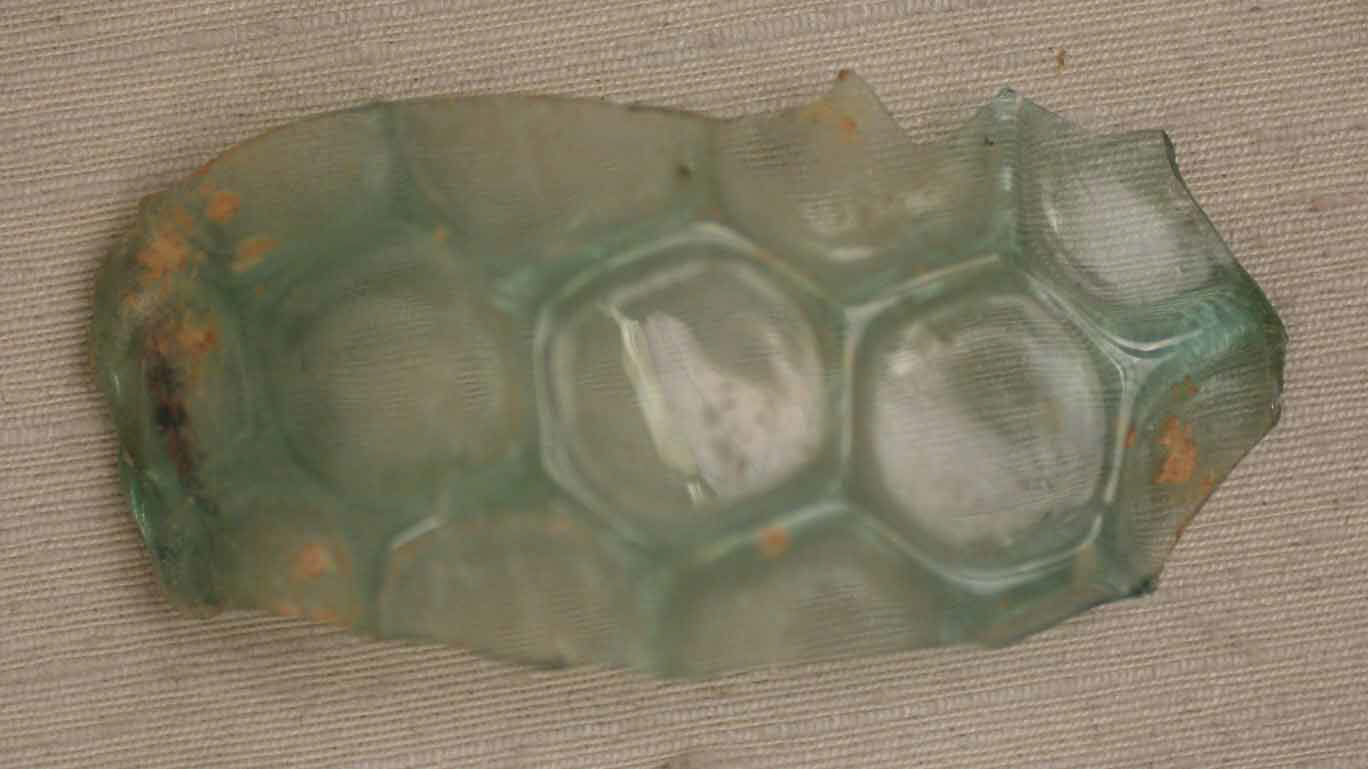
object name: fragment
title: Glass Fragment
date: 501-700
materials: glass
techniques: glassblowing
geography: iraq